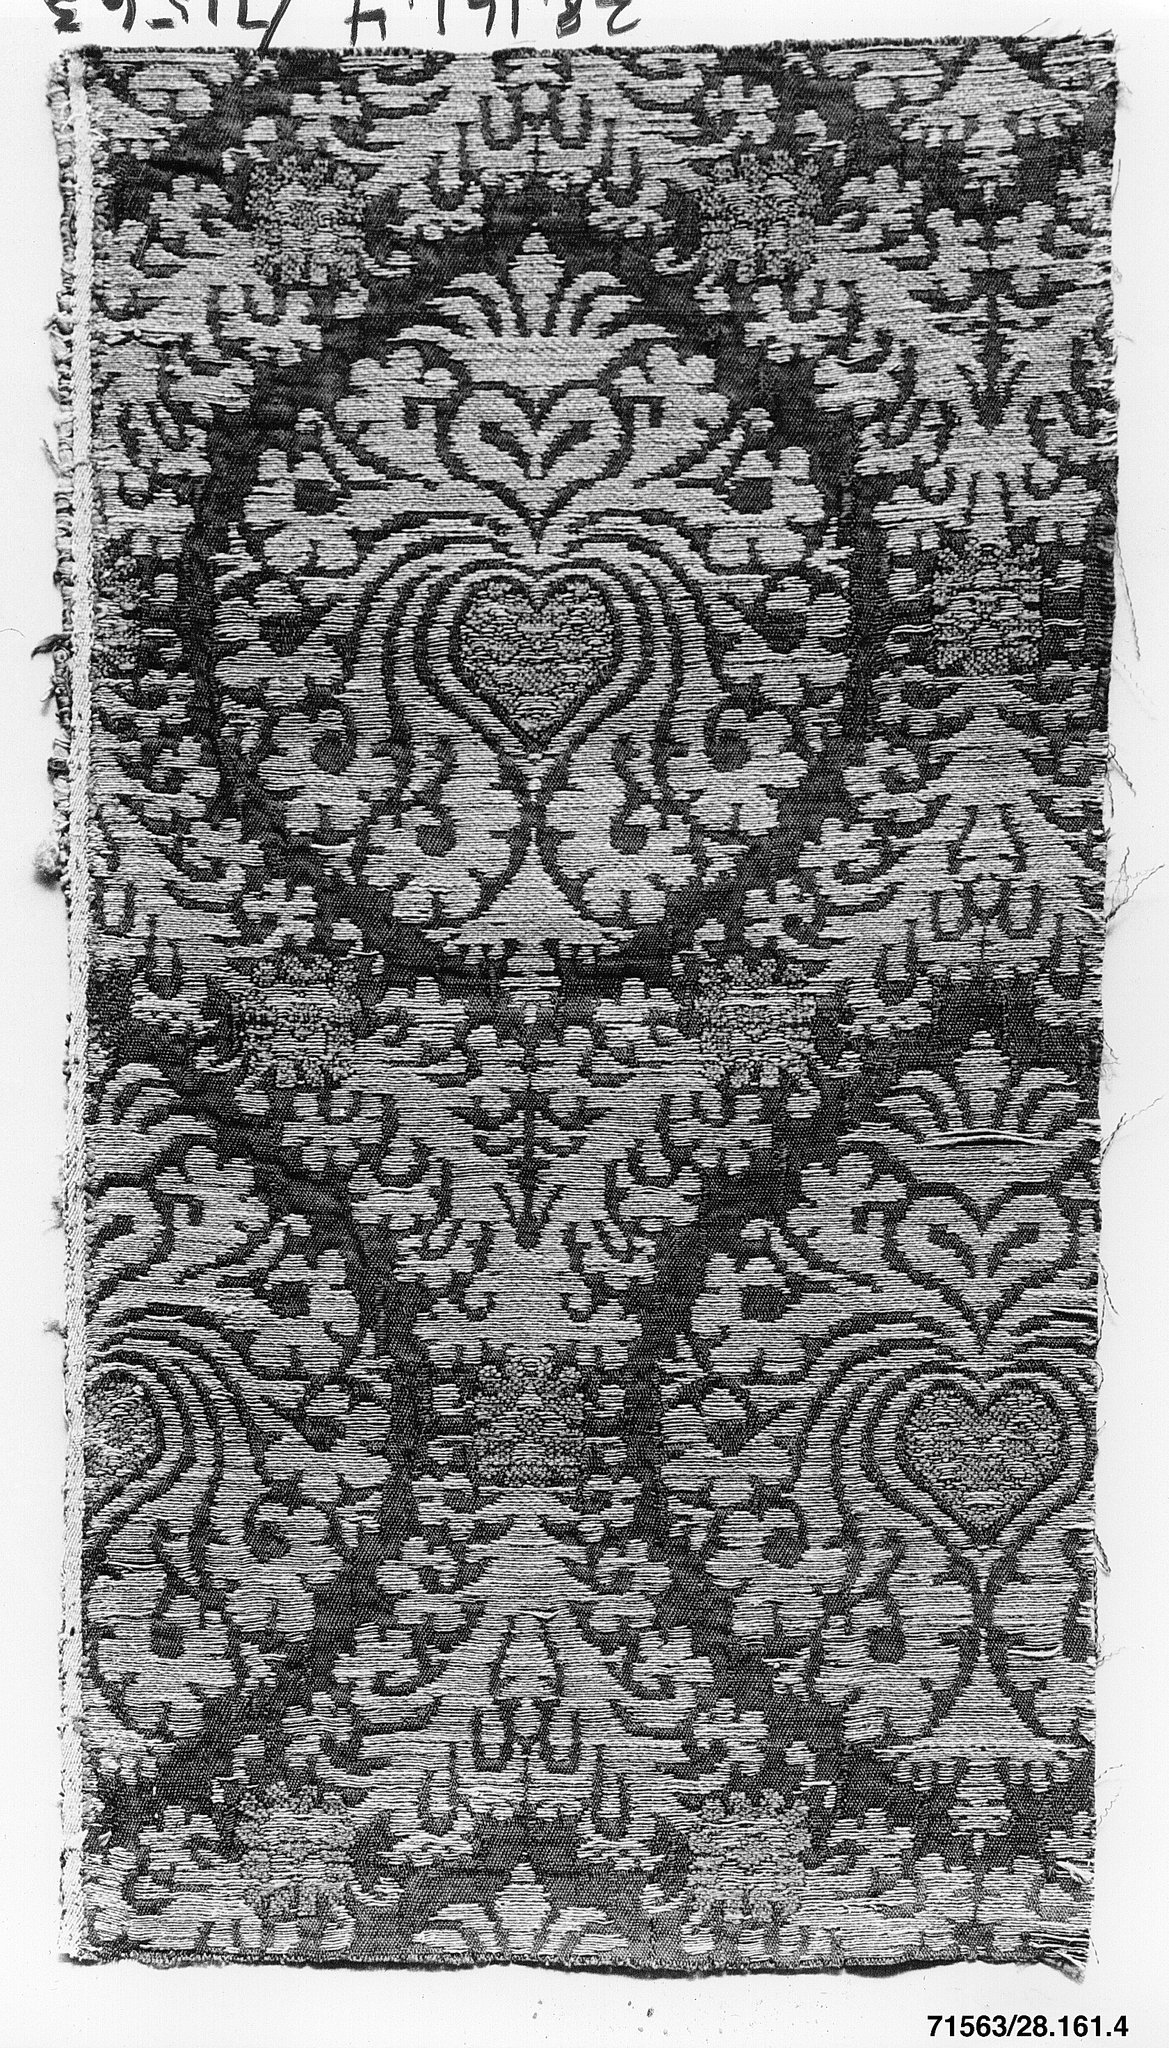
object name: piece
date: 1501-1600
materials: linen, metal thread, silk